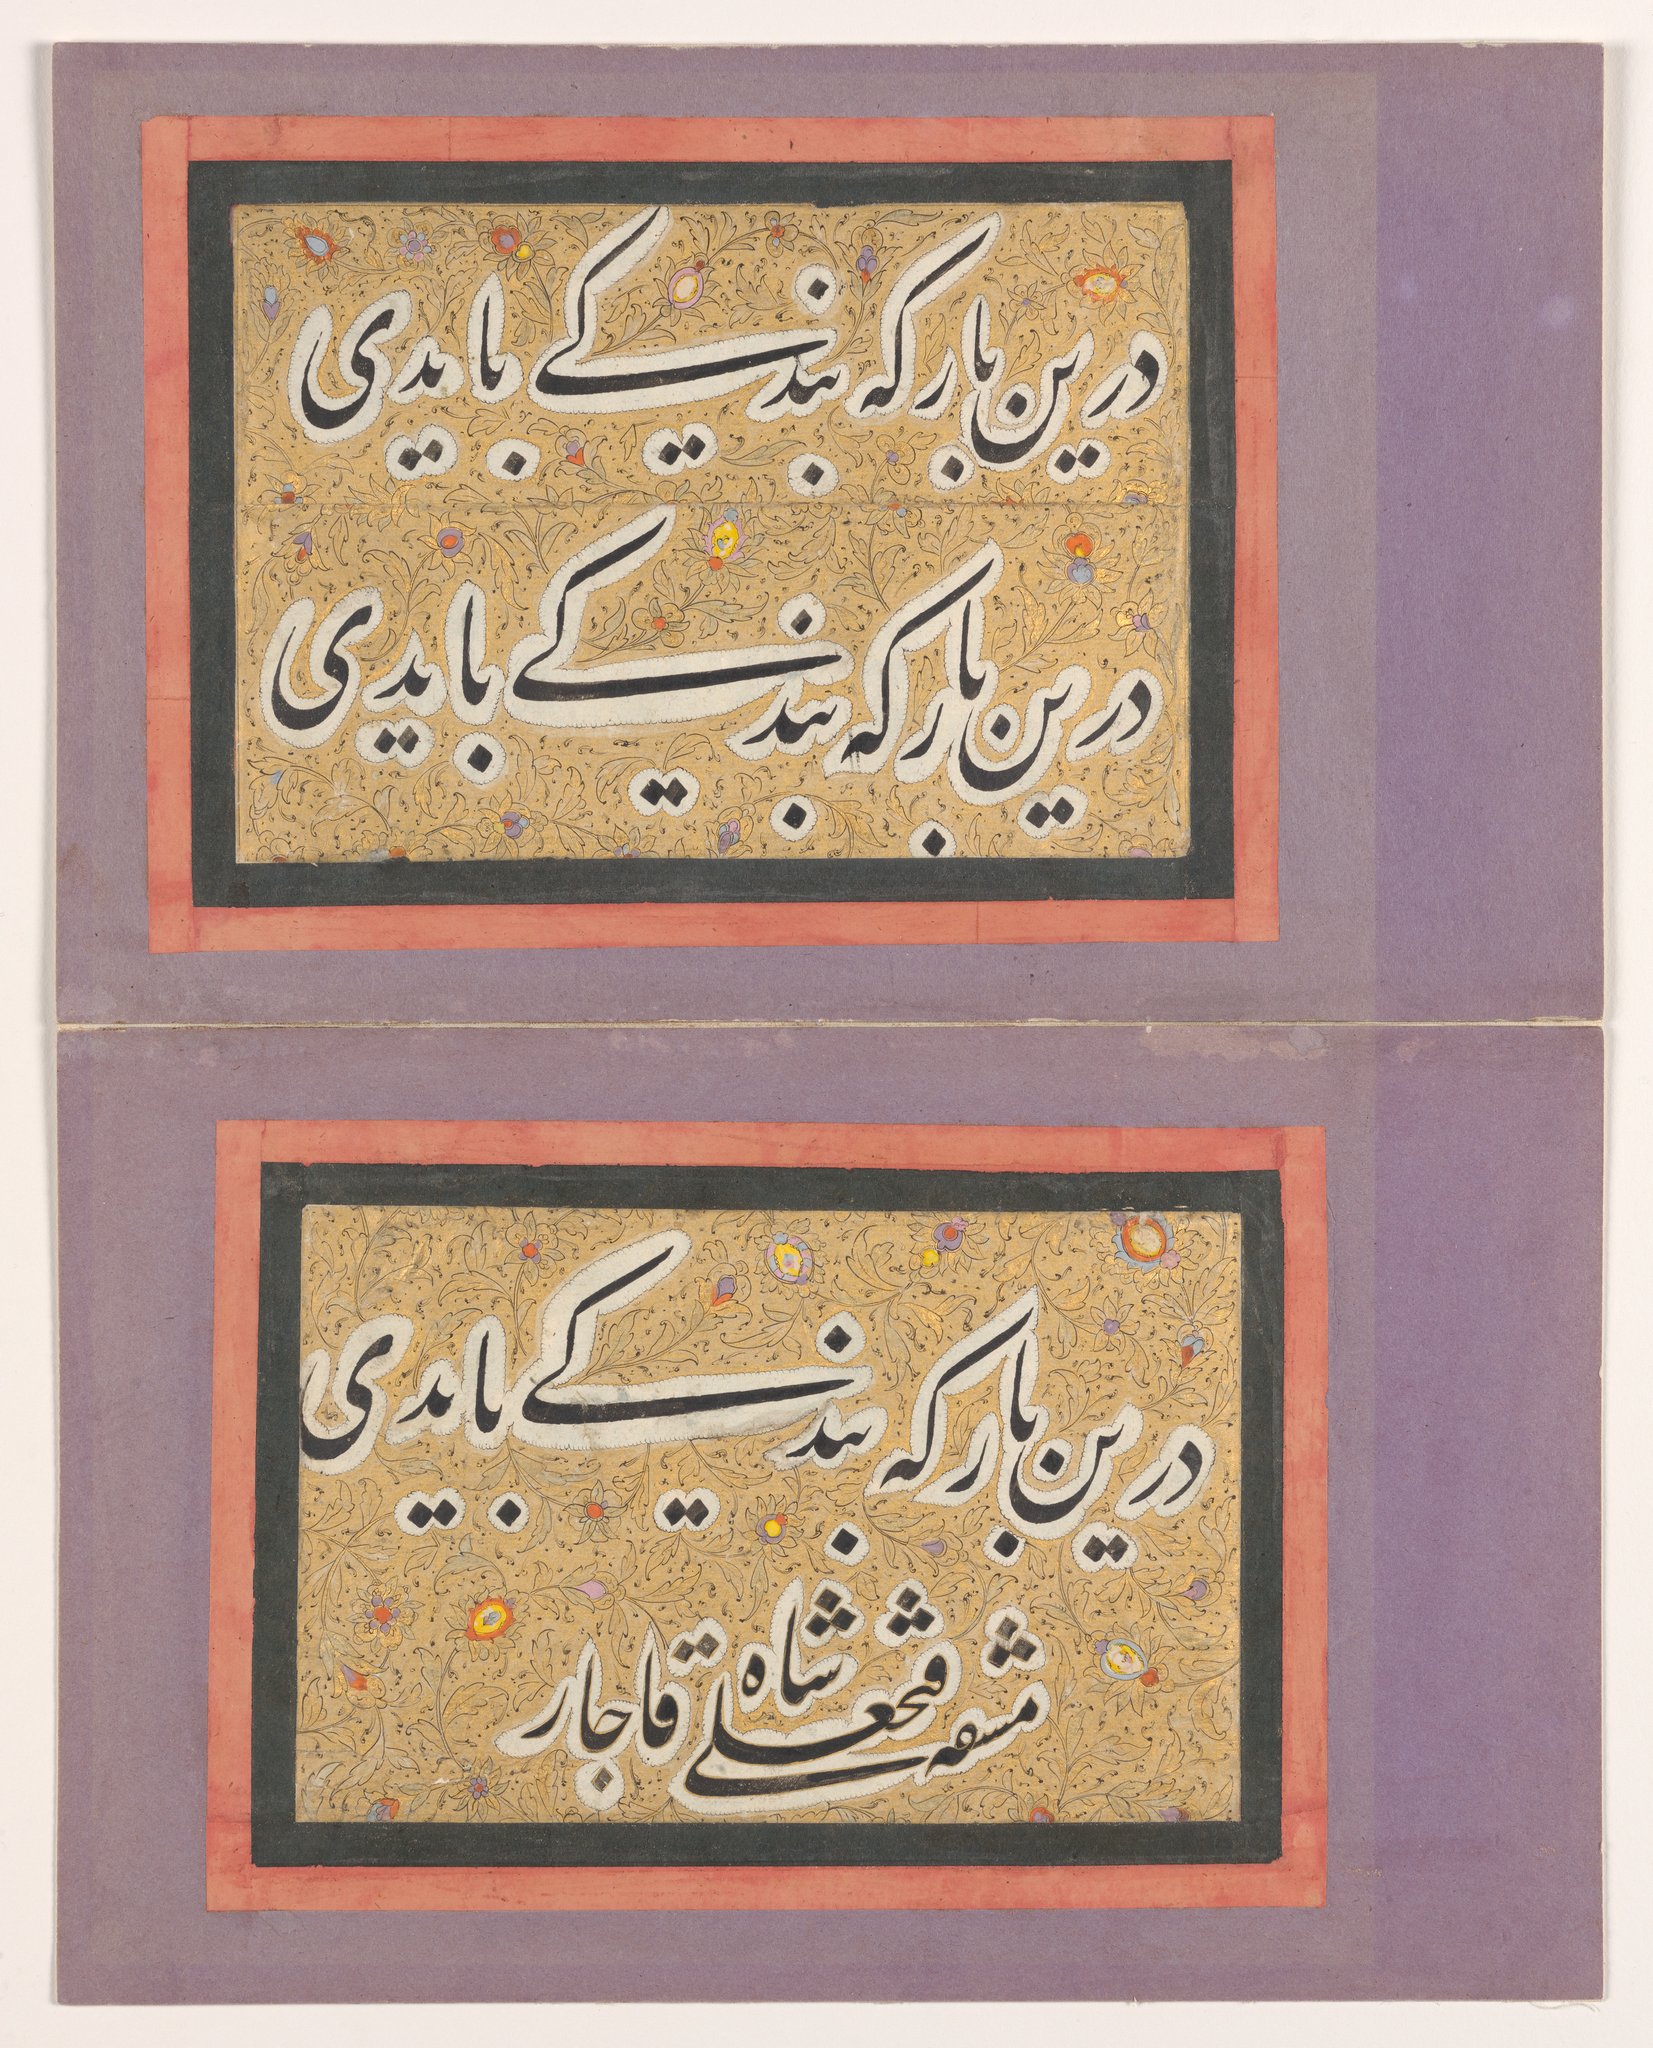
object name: non illustrated album leaf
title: Double Album Leaf with Calligraphic Exercise by Fath 'Ali Shah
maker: fath 'ali shah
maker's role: calligrapher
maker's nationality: iranian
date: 1801-1850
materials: gold, ink, paper, watercolor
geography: iran